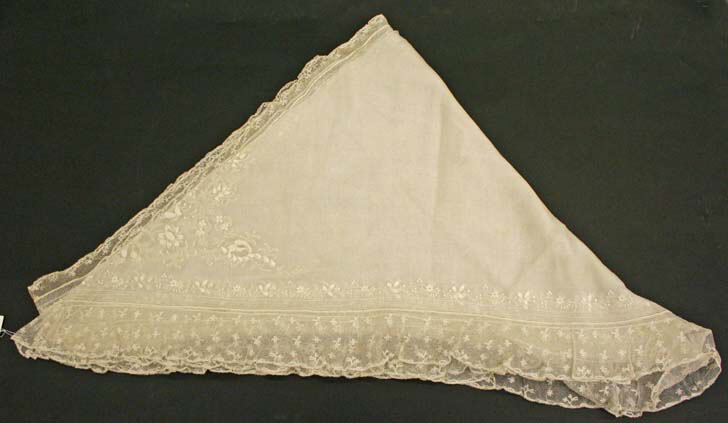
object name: fichu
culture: french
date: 1785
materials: cotton